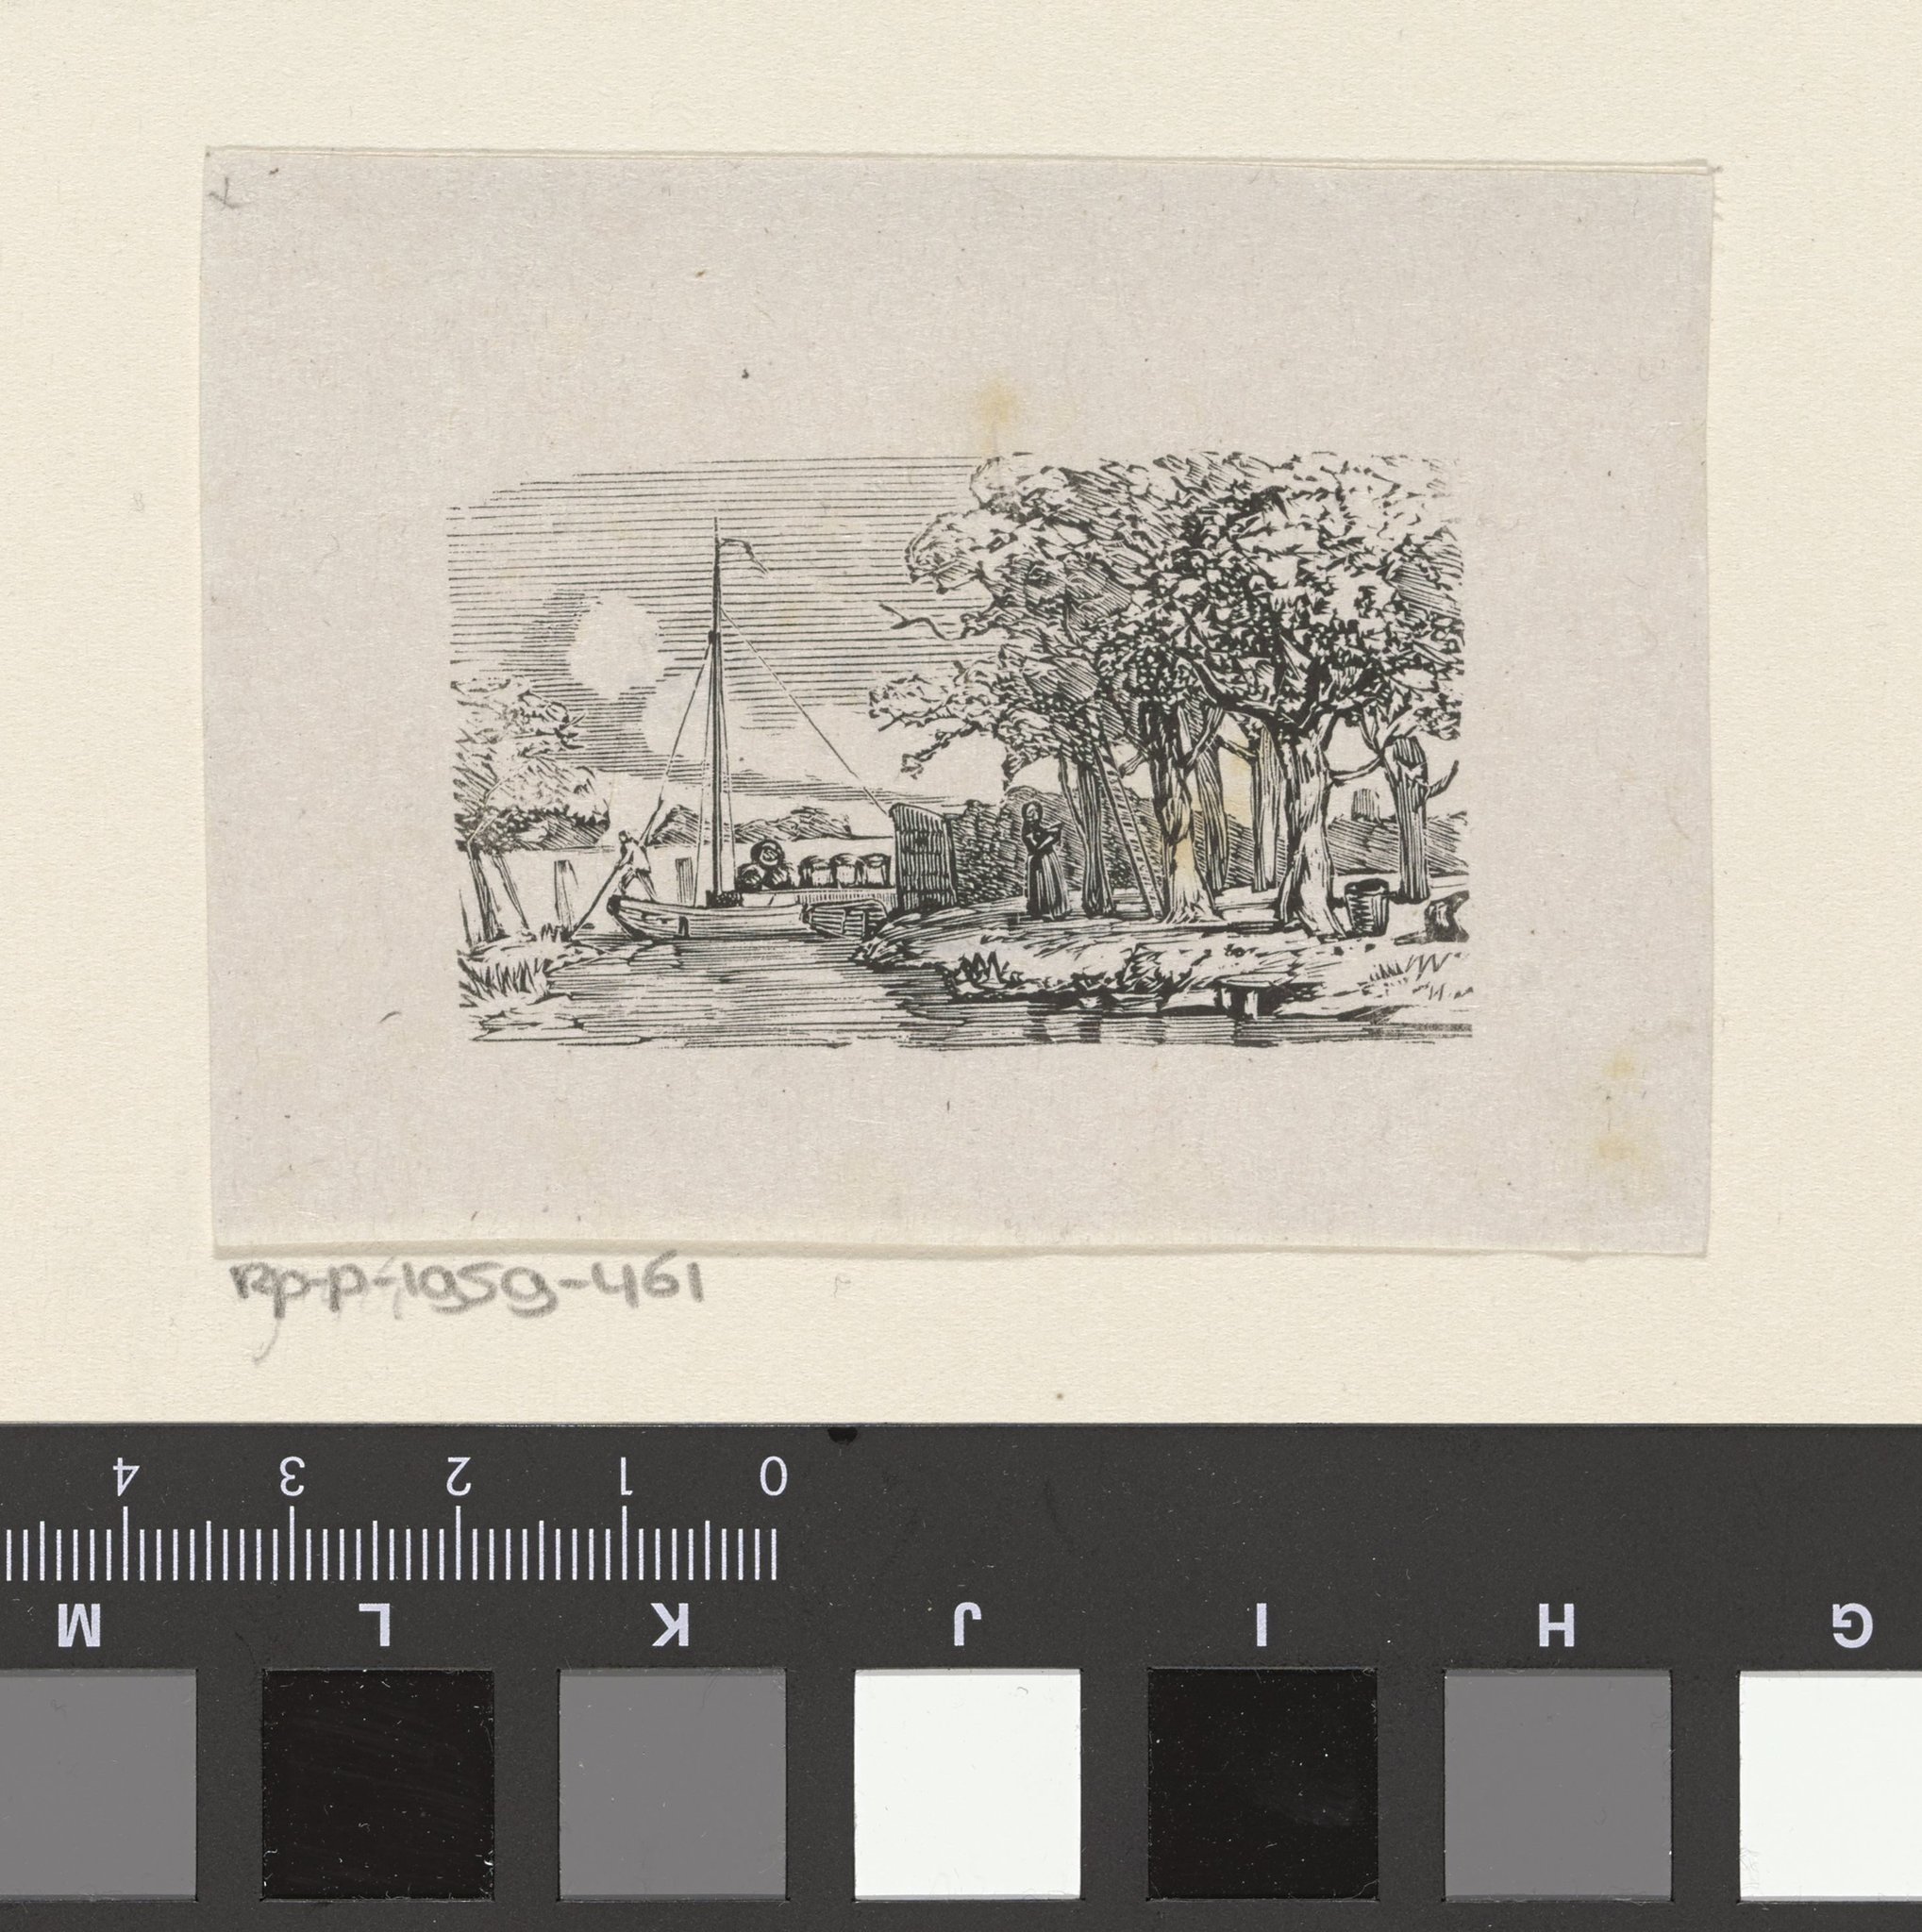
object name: print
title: Maanden van het jaar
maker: isaac weissenbruch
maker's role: print maker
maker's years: 1826-1912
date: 1836-1912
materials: paper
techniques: engraving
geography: netherlands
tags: the twelve months represented by scenes showing human activities, usually in a landscape; so-called 'labours of the months', adult woman (+ standing), adult man (+ standing), orchard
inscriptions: collector's mark: Lugt 2228